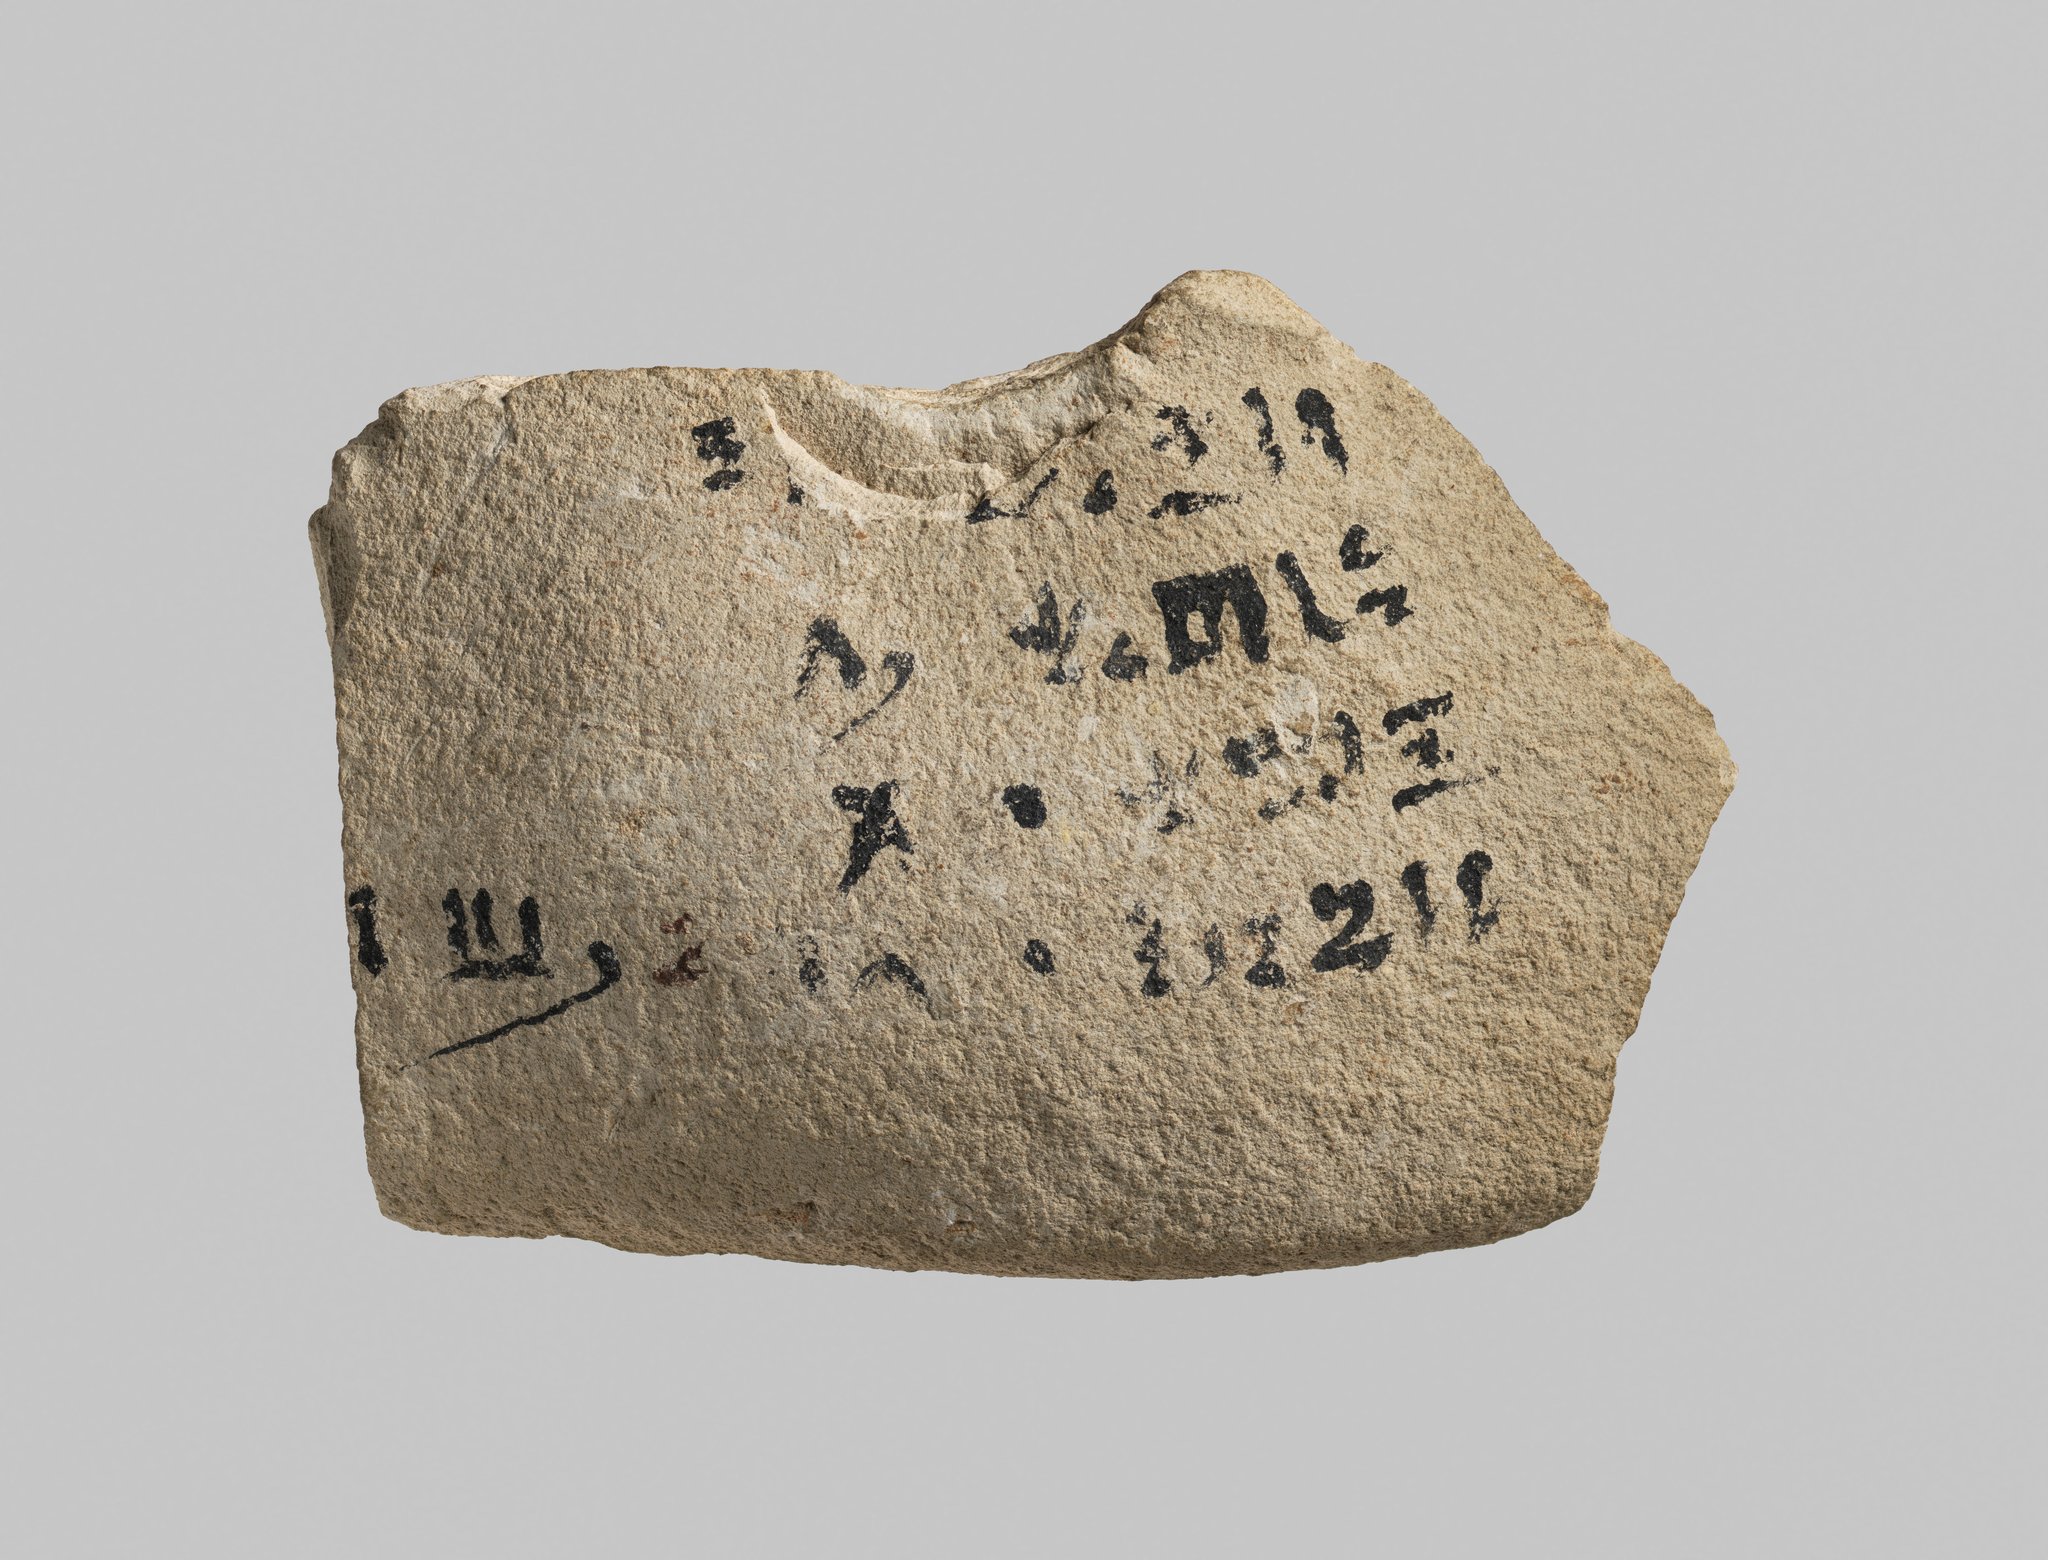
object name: ostracon, hieratic, account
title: Ostracon with hieratic inscription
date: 1295-525 BCE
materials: ink, limestone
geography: egypt